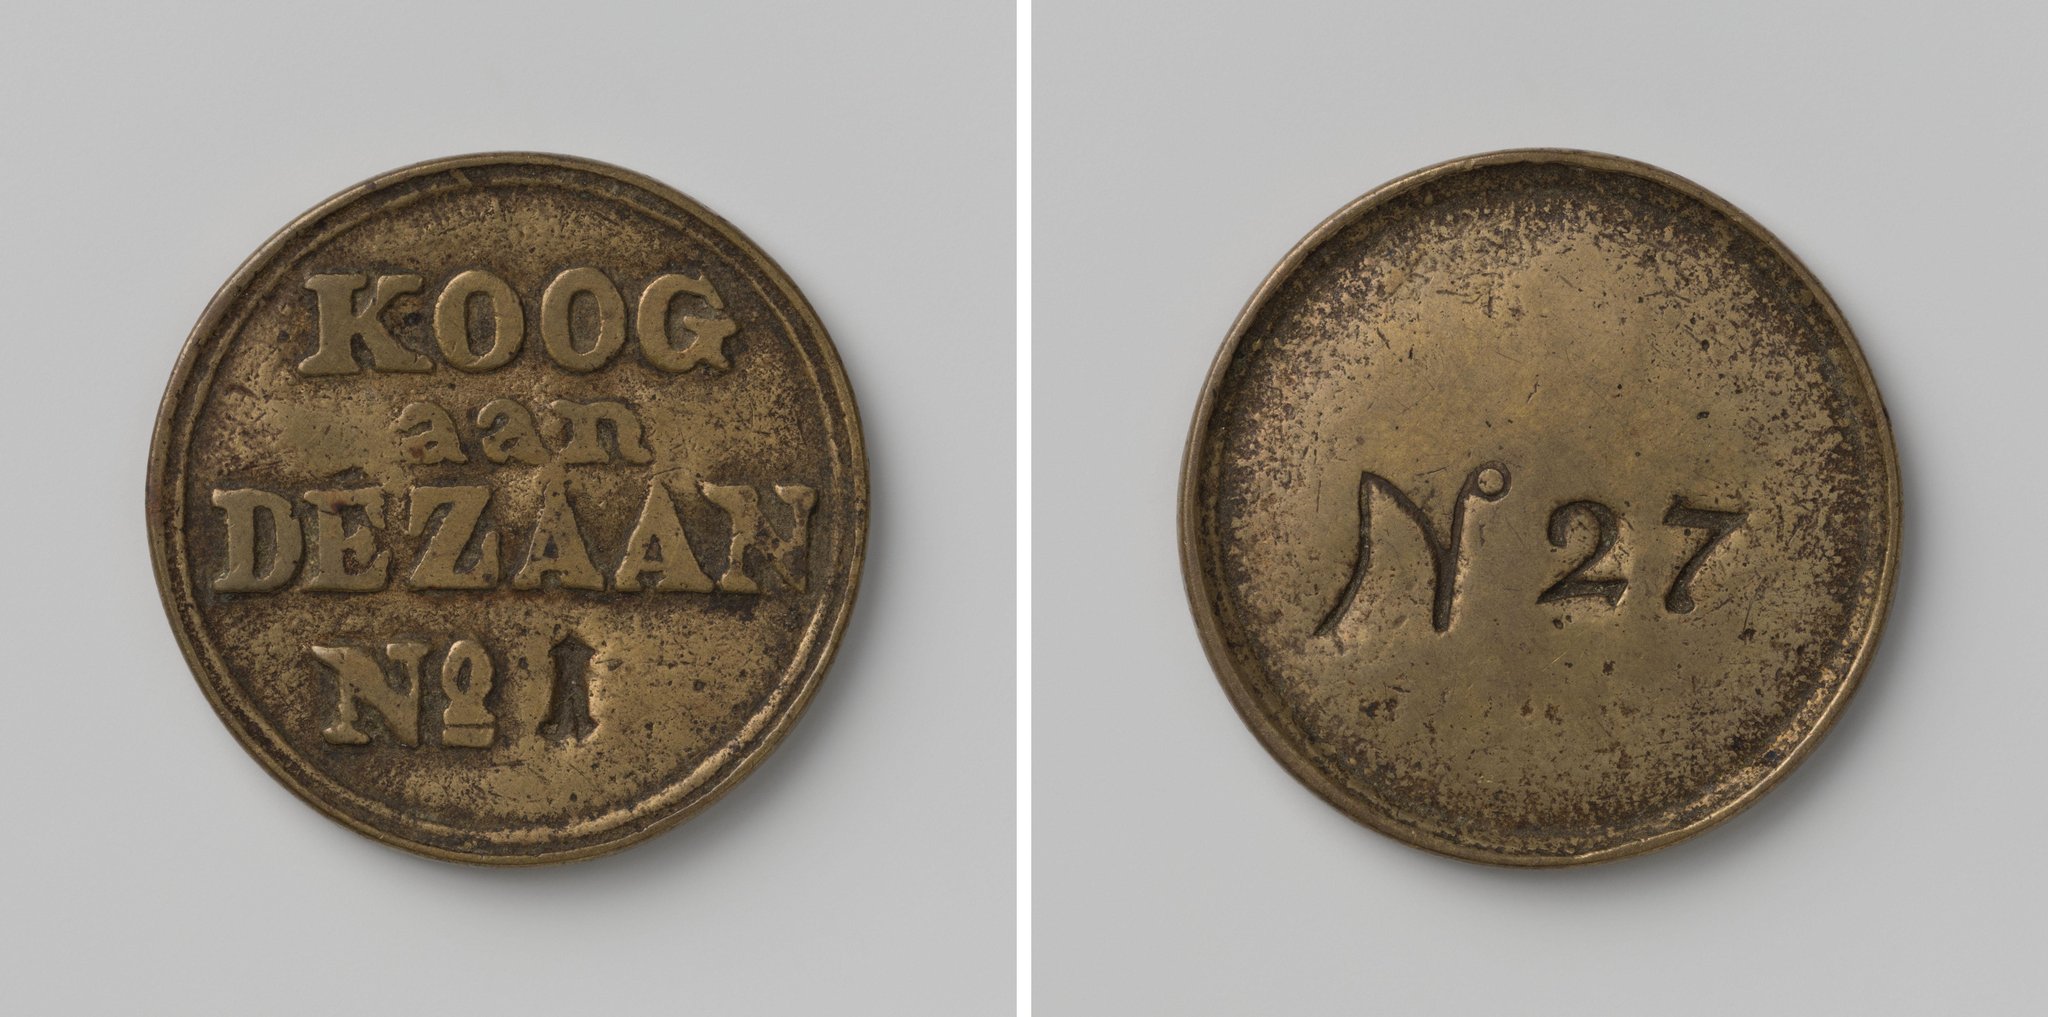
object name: medal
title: Koog aan de Zaan, brandspuitpenning van spuit 1 met no. 27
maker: Anonymous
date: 1680-1800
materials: brass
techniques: casting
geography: koog aan de zaan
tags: koog aan de zaan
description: Messing penning. Voorzijde: opschrift boven cijfer no. 1. Keerzijde: cijfer no. 27